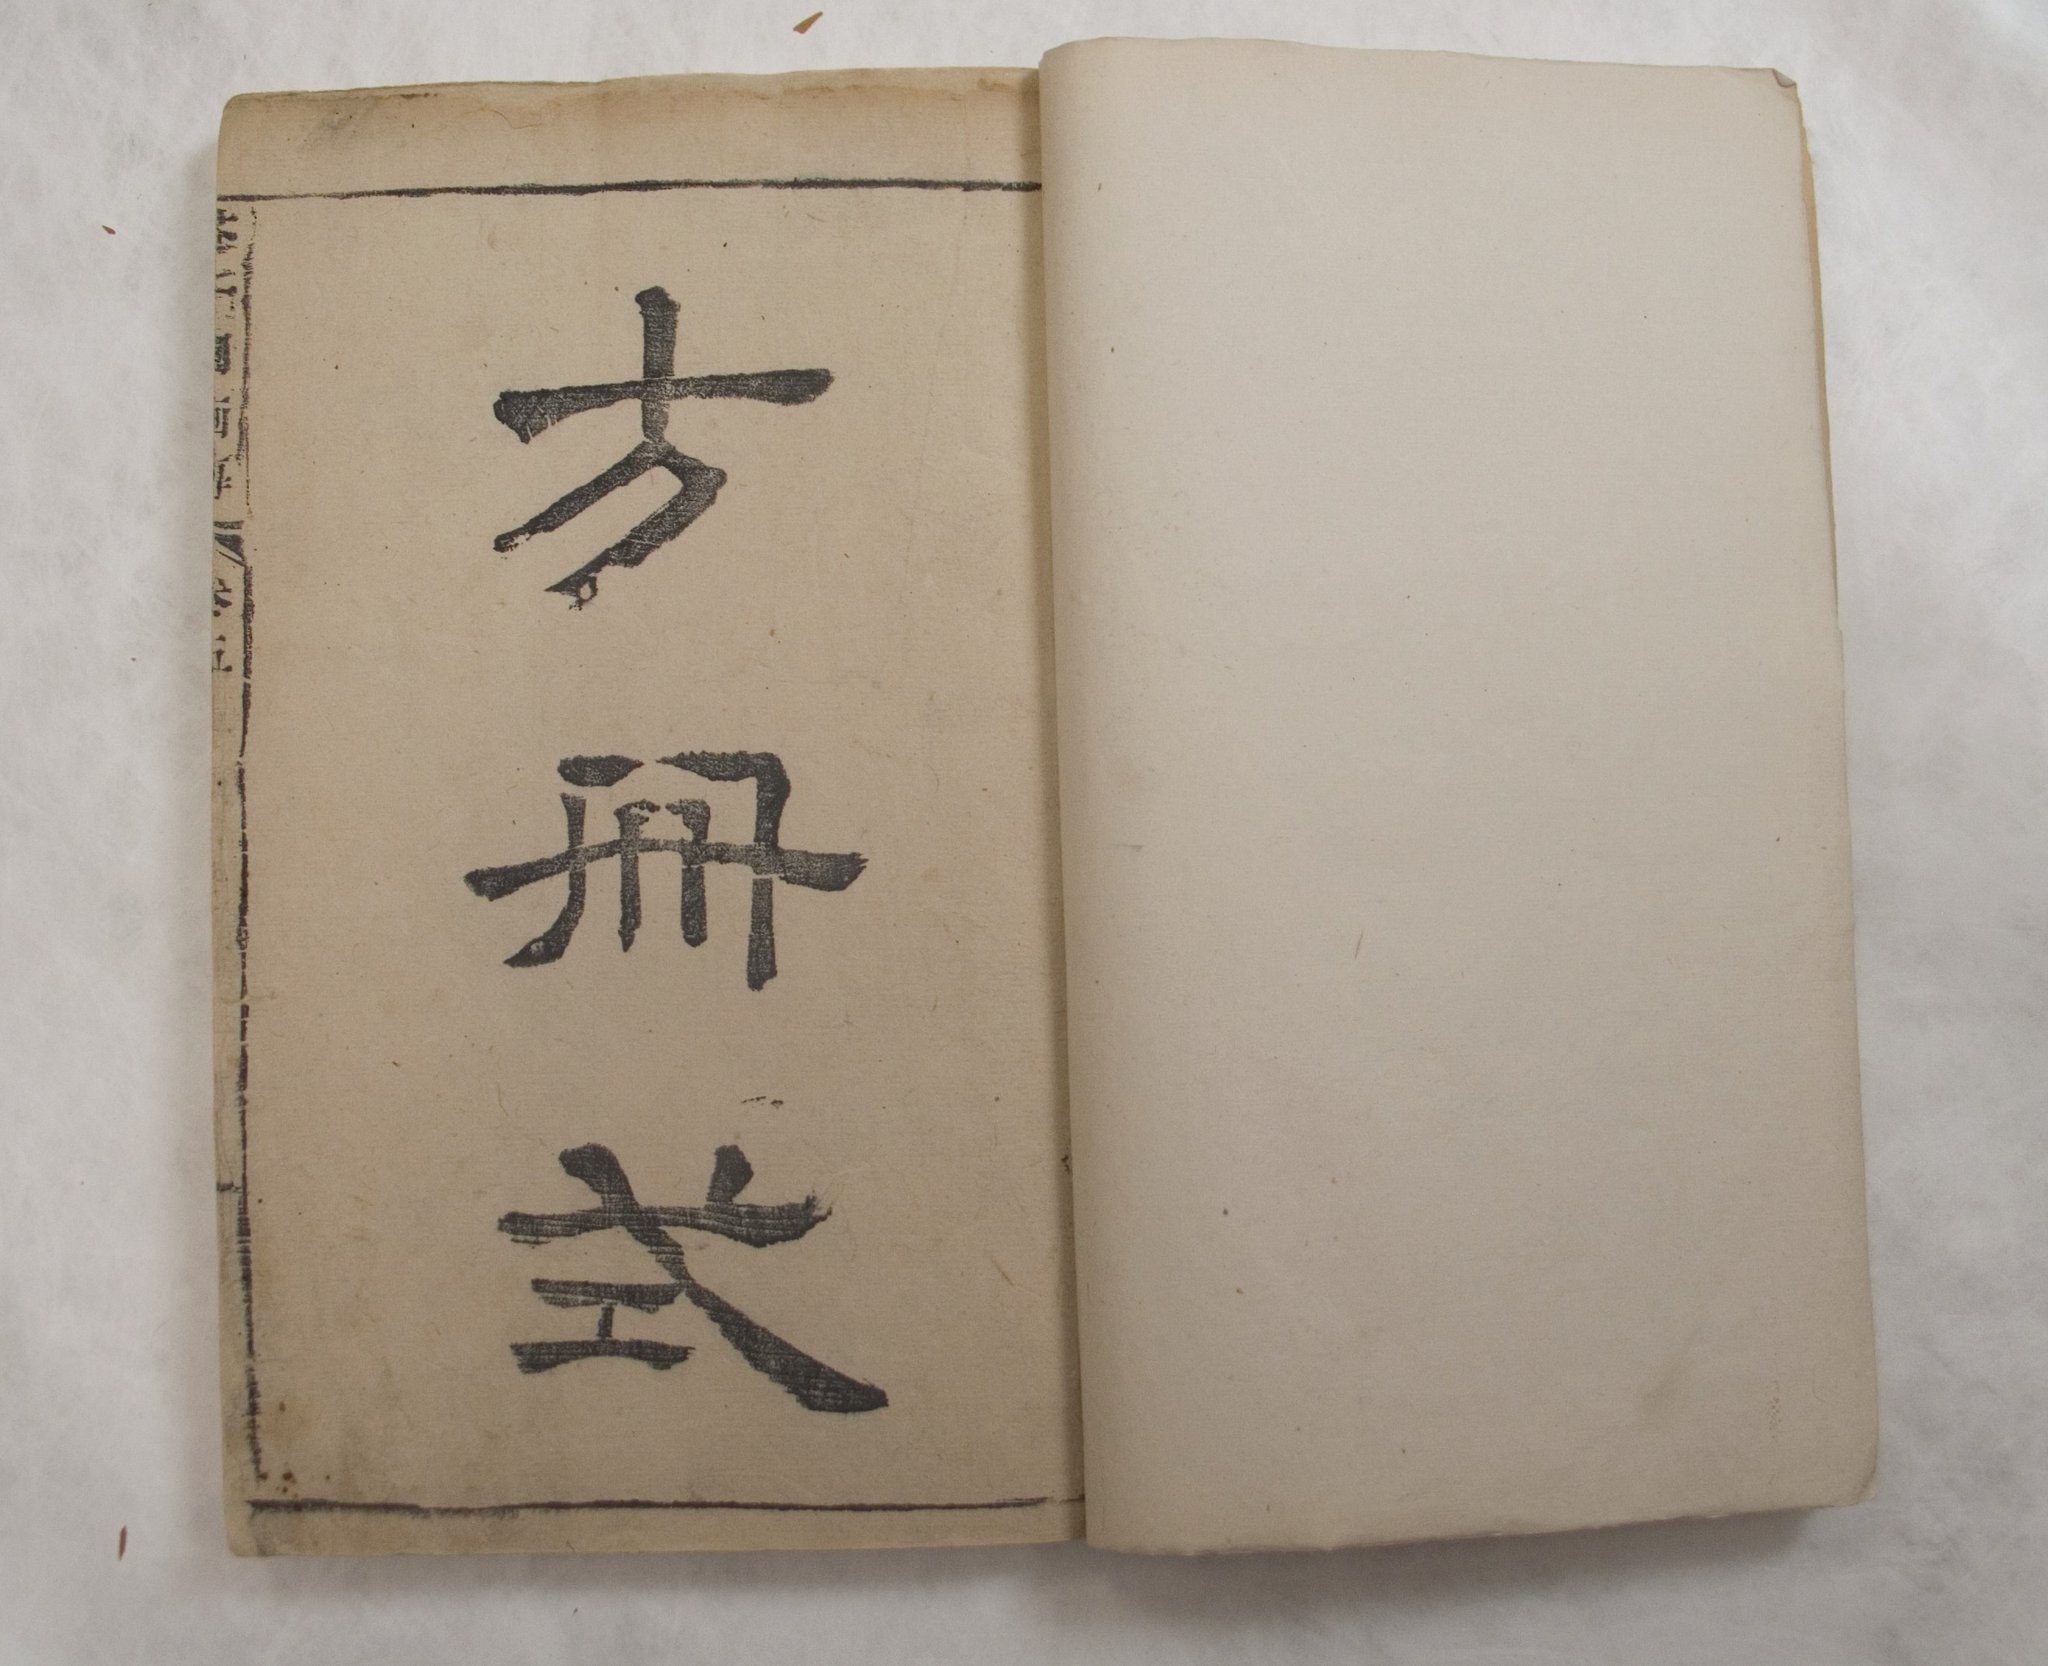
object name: illustrated book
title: The Mustard Seed Garden Painting Manual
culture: chinese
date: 1662-1722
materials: ink, paper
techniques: woodblock print